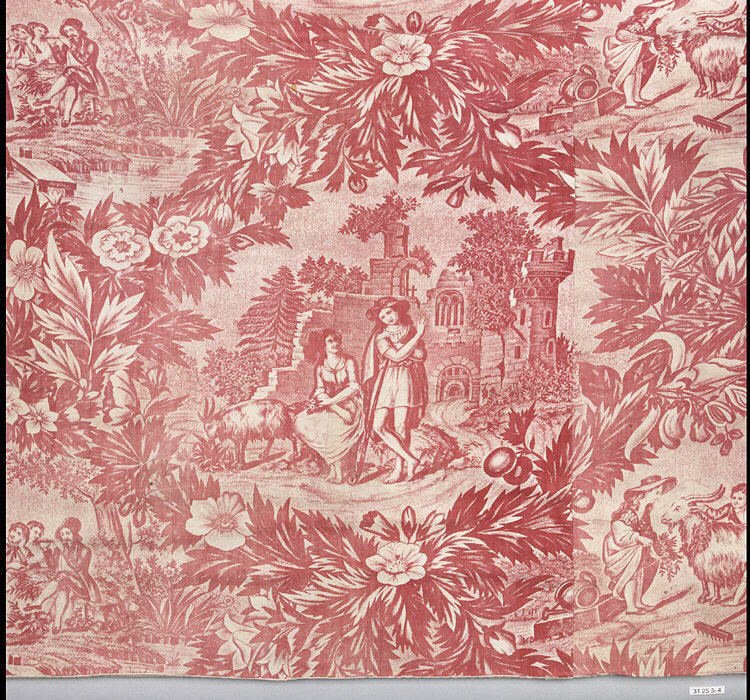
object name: fragment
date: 1801-1900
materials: cotton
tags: animals,women,flowers,trees